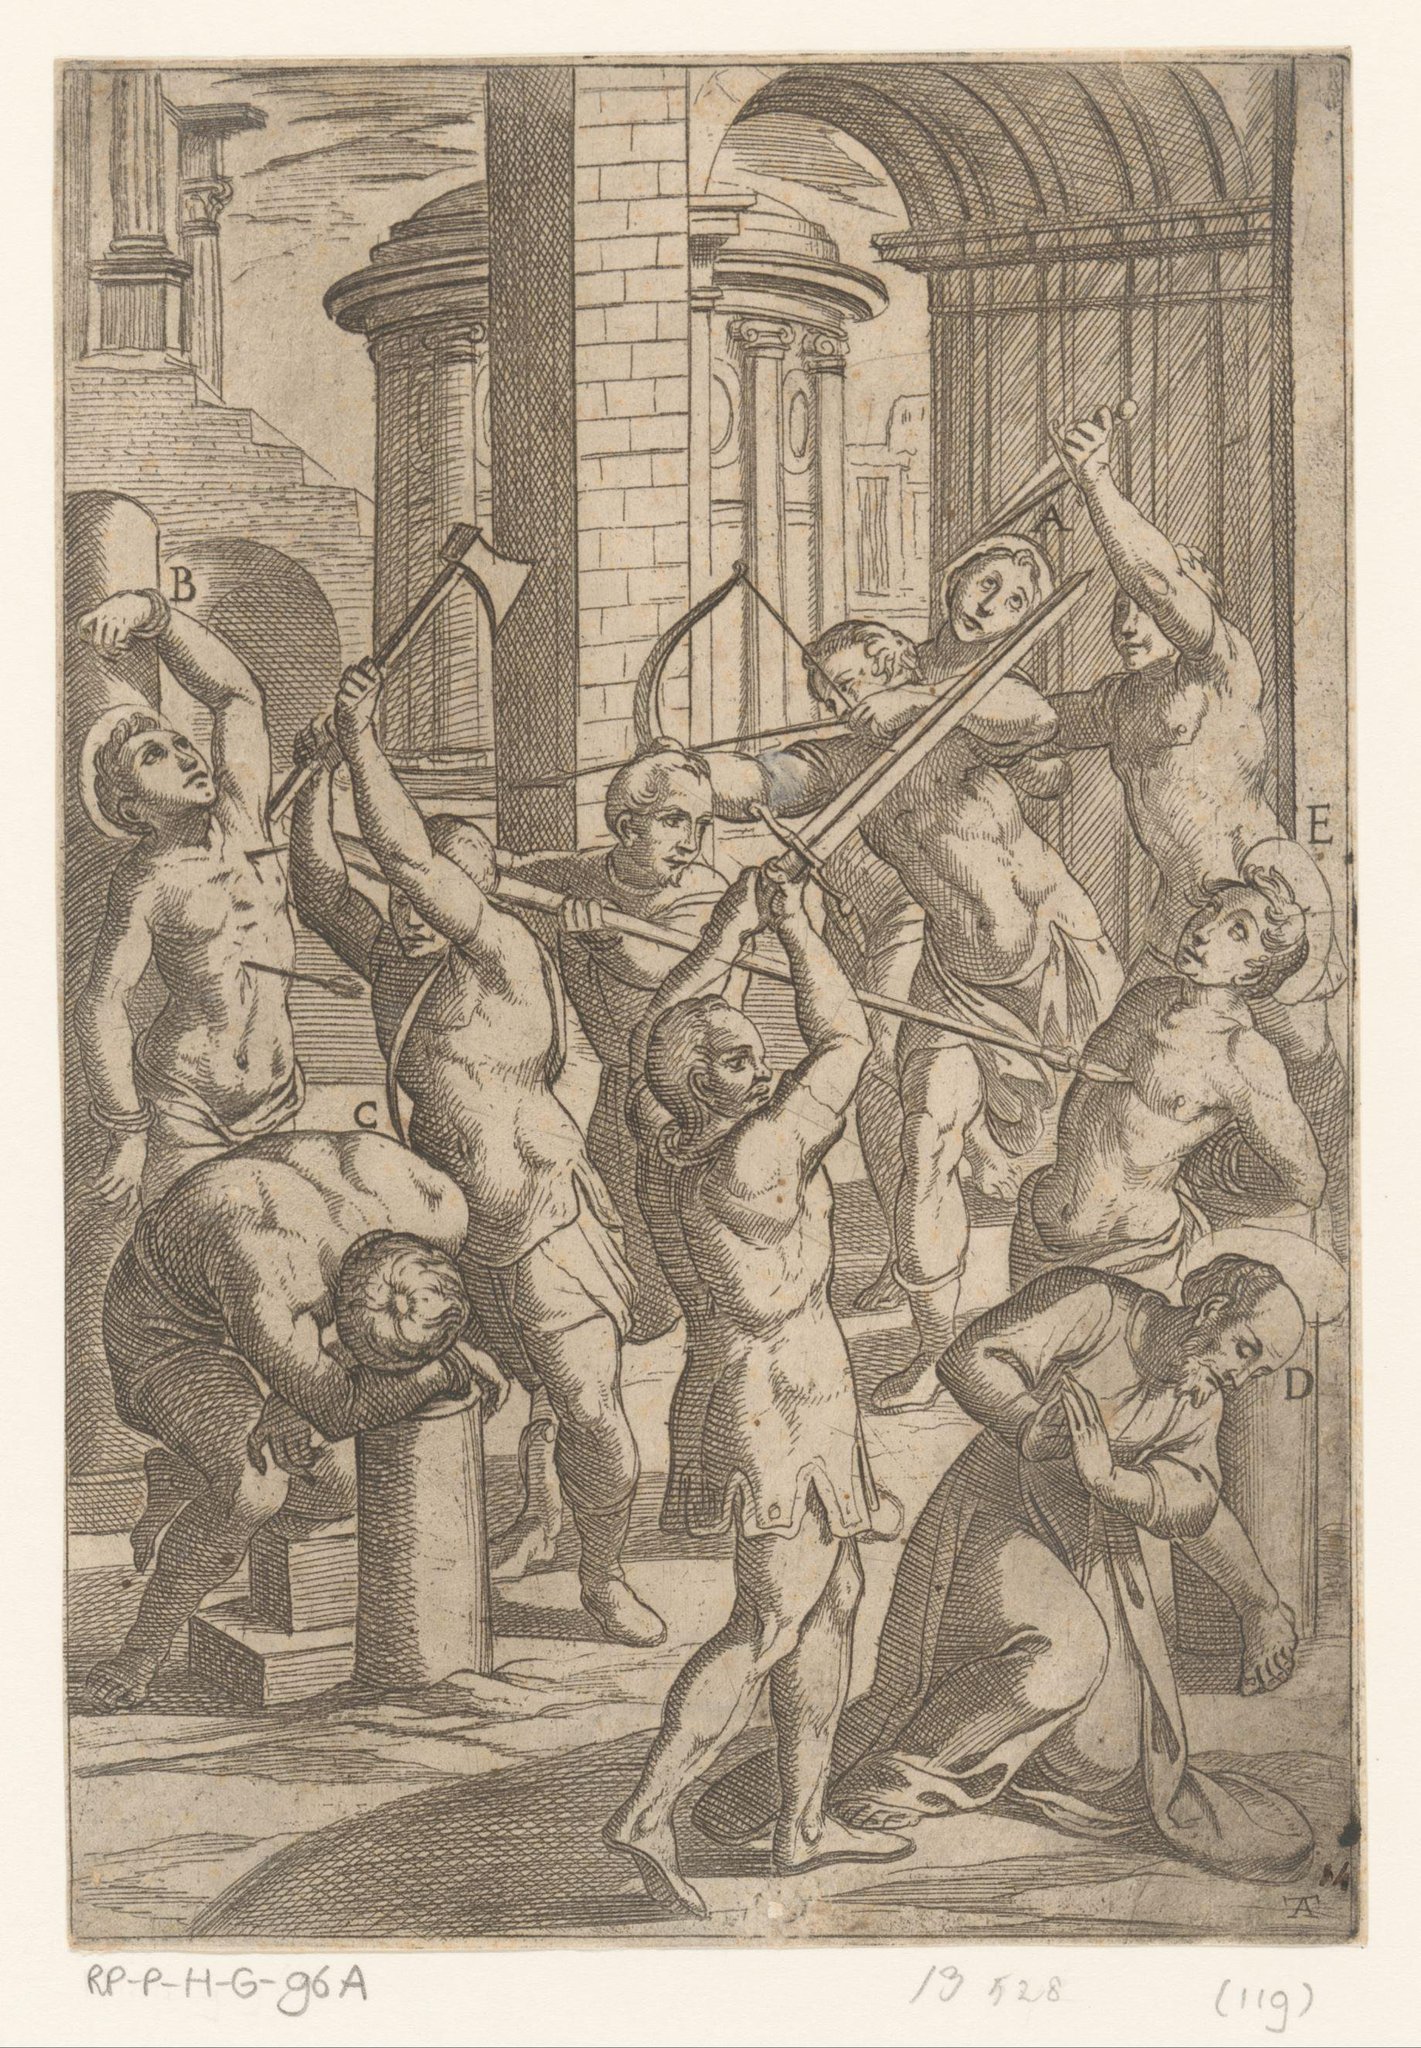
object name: print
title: Varia tormentorum et supplicioru crudelium (...)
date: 1565-1630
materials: paper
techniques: etching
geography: italy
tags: violent death ~ maltreatment, torture, torture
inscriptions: collector's mark: ‘Hinloopen’, collector's mark: Lugt 11, number: ‘14’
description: Deze prent maakt deel uit van een reeks van 47 prenten (+ titelprent) met voorstellingen van martelmethoden. Deze prenten zijn in een andere editie gebruikt als illustraties voor Antonio Gallonio's 'Trattato degli Instrumenti di Martirio e delle Varie Maniere di Martoriare Usate dai Gentili contro Christiani' (Rome, Ascanio en Girolamo Dongangeli, 1591). Midden onder nummer 119 weggekrast.